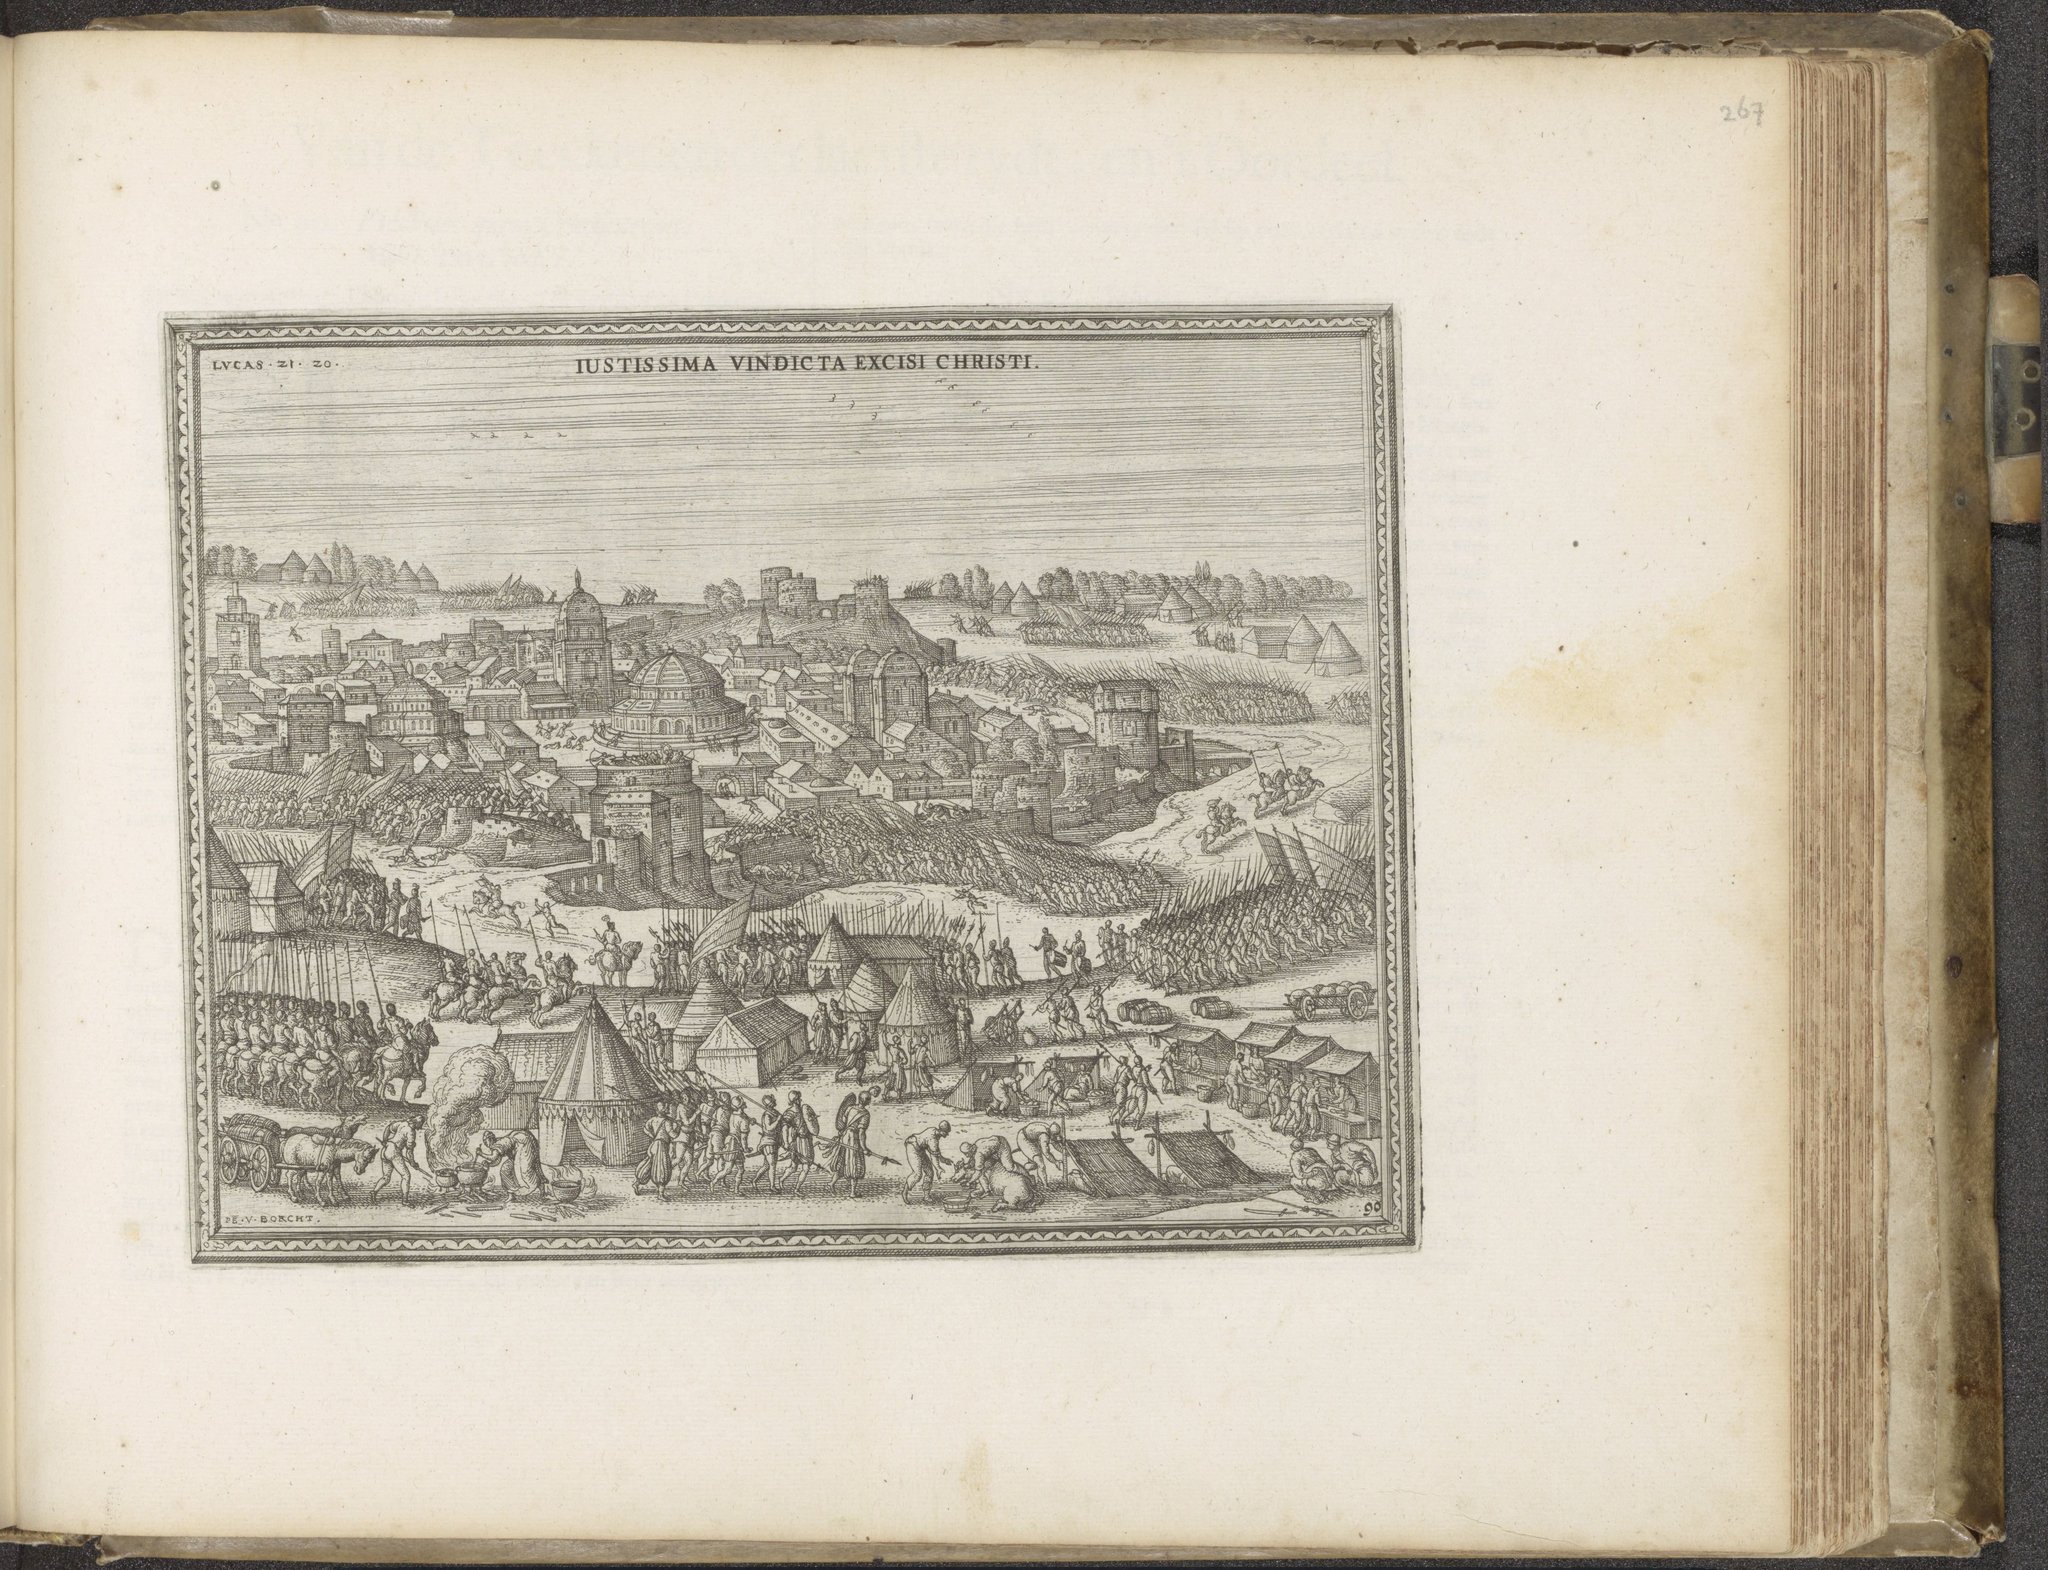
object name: print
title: Justissima vindicta excisi Christi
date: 1582-1593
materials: paper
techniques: etching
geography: amsterdam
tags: signs in nature and in the sky prophesying the destruction of jerusalem (luke 21:25)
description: Jeruzalem is door legertroepen omsingeld. Christus voorspelde dat bij deze aanblik de verwoesting van de stad nabij is (Luc. 21). Linksonder legt een man hout op het vuur en staat een vrouw in een pot te roeren. Rechtsonder twee poepende mannen op hun hurken. Rechtsonder het nummer dat de prent in een eerdere uitgave had: 90. De prent maakt deel uit van een album.